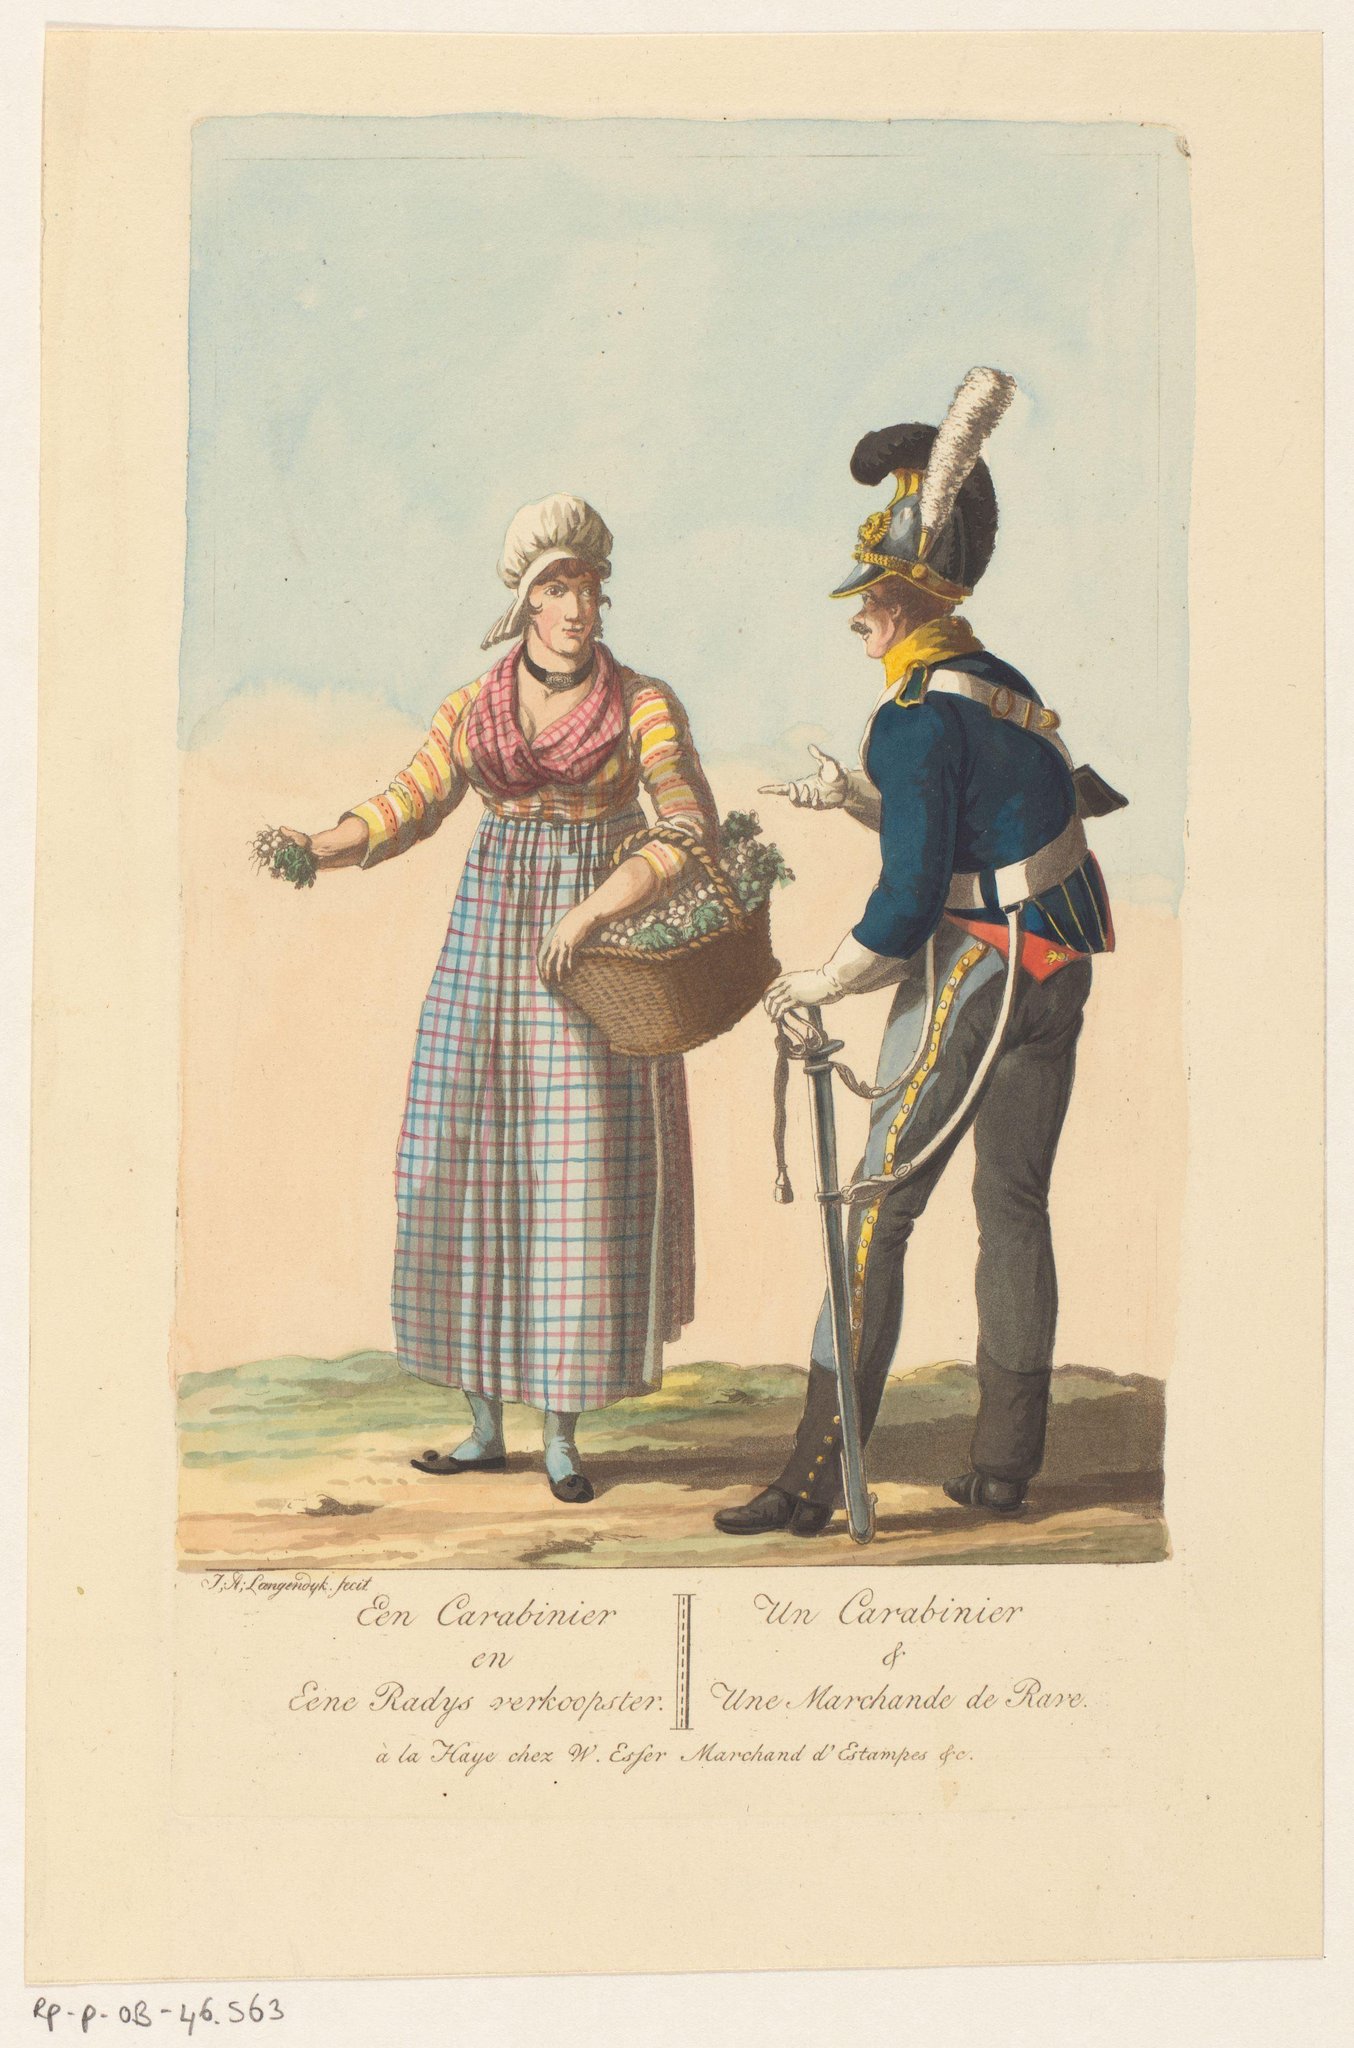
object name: print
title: Een Carabinier en eene Radys verkoopster / Un Carabinier & Une Marchande de Rave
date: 1816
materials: paper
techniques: color aquatint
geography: the hague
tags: street-trader, military discipline (+ cavalry, horsemen), (non-fruit) products of plants or trees: radish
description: Een cavaleriesoldaat en een radijsverkoopster voeren een gesprek. De vrouw links draagt een mand met radijzen aan de arm, de soldaat rechts steunt op zijn zwaard terwijl hij spreekt.